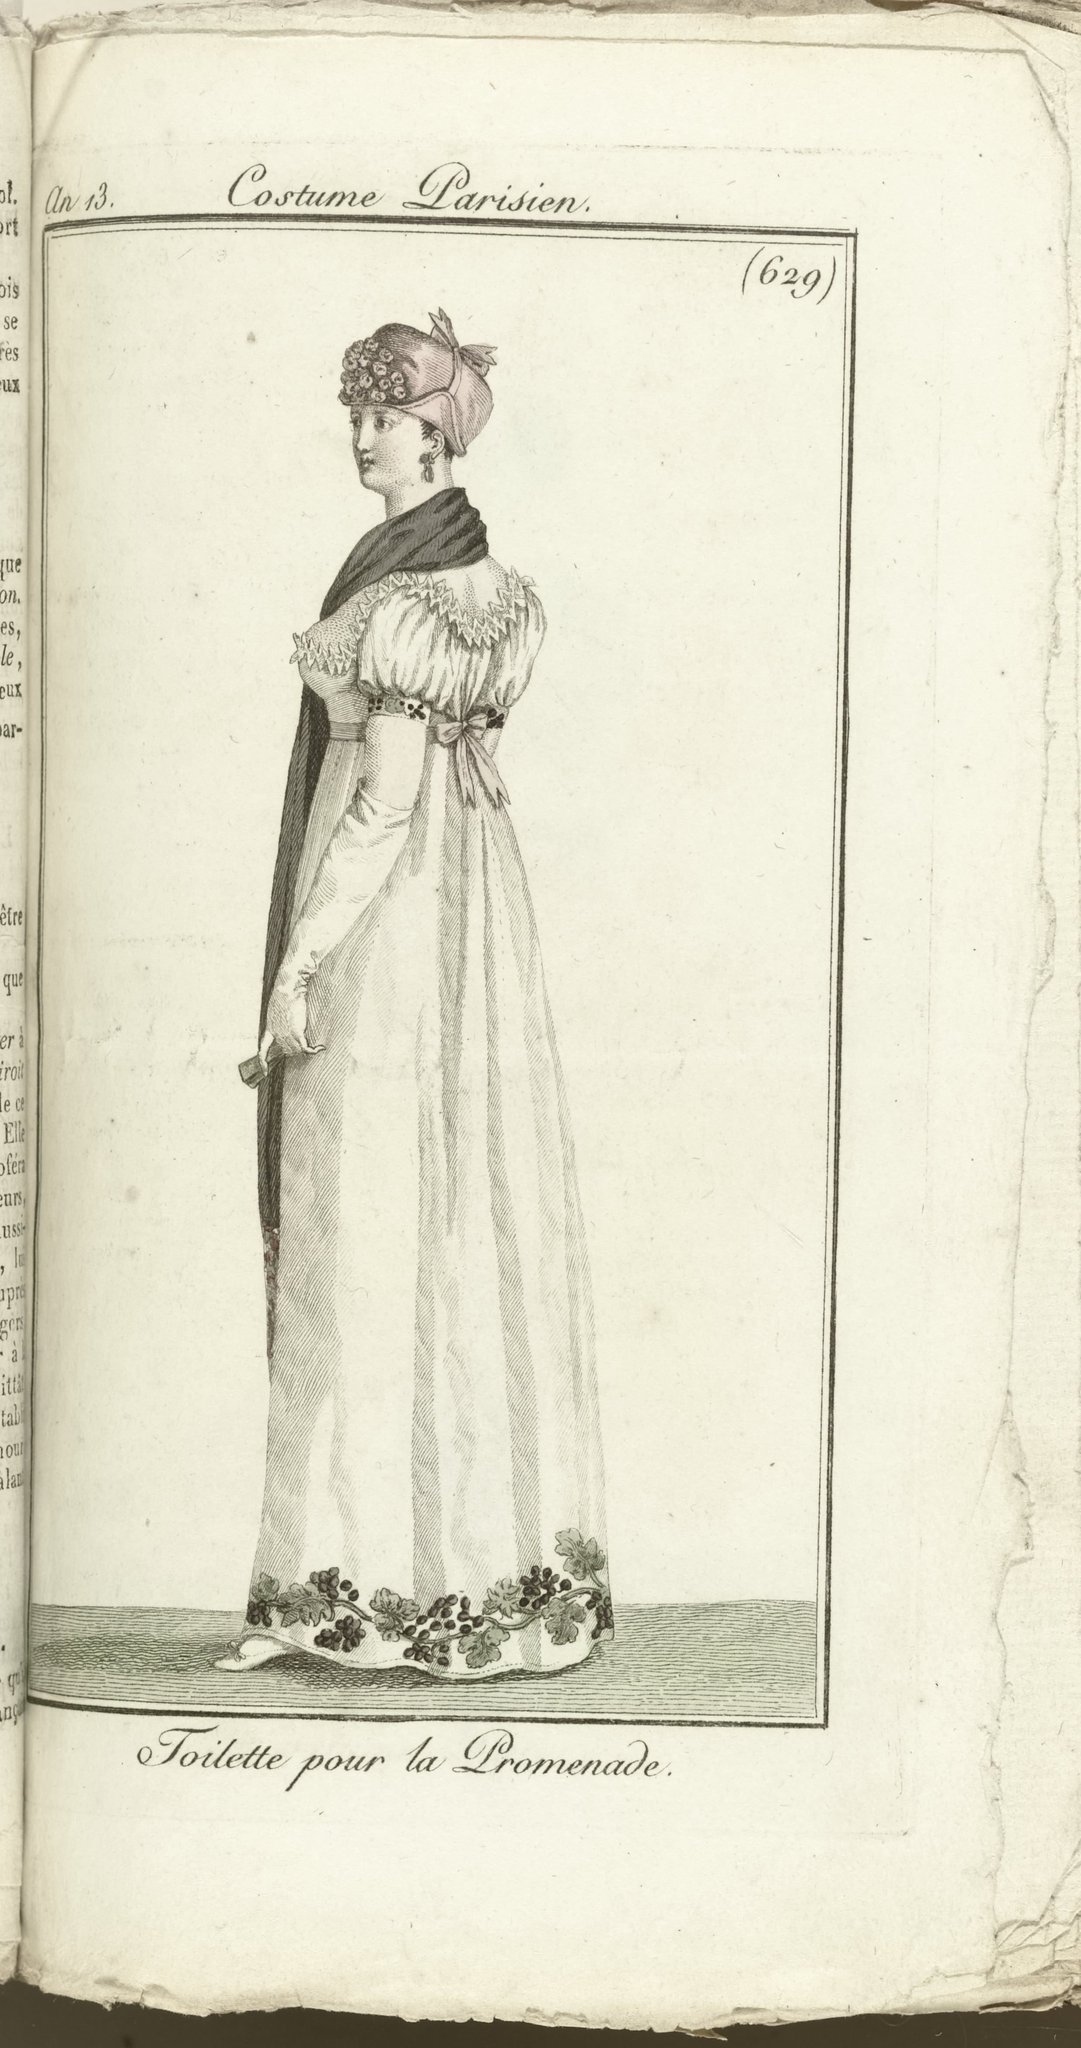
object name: fashion print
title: Journal des Dames et des Modes, Costume Parisien, 1805, An 13 (629) Toilette pour la Promenade.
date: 1805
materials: paper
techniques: engraving, hand coloring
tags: ear-rings (+ women's clothes), head-gear: toque (+ women's clothes), gloves, mittens (long gloves) (+ women's clothes), dress, gown: walking dress (+ women's clothes), neck-gear ~ clothing (shawl) (+ women's clothes), fashion plates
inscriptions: title: ‘Toilette pour la Promenade.’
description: Vrouw naar links, gekleed in wandelkostuum, bestaand uit een witte japon met korte pofmouwen, een rand van geborduurde druivenranken aan de zoom van de rok. Roze lint met strik als ceintuur. Groene lange sjaap, roze toque, oorbellen.